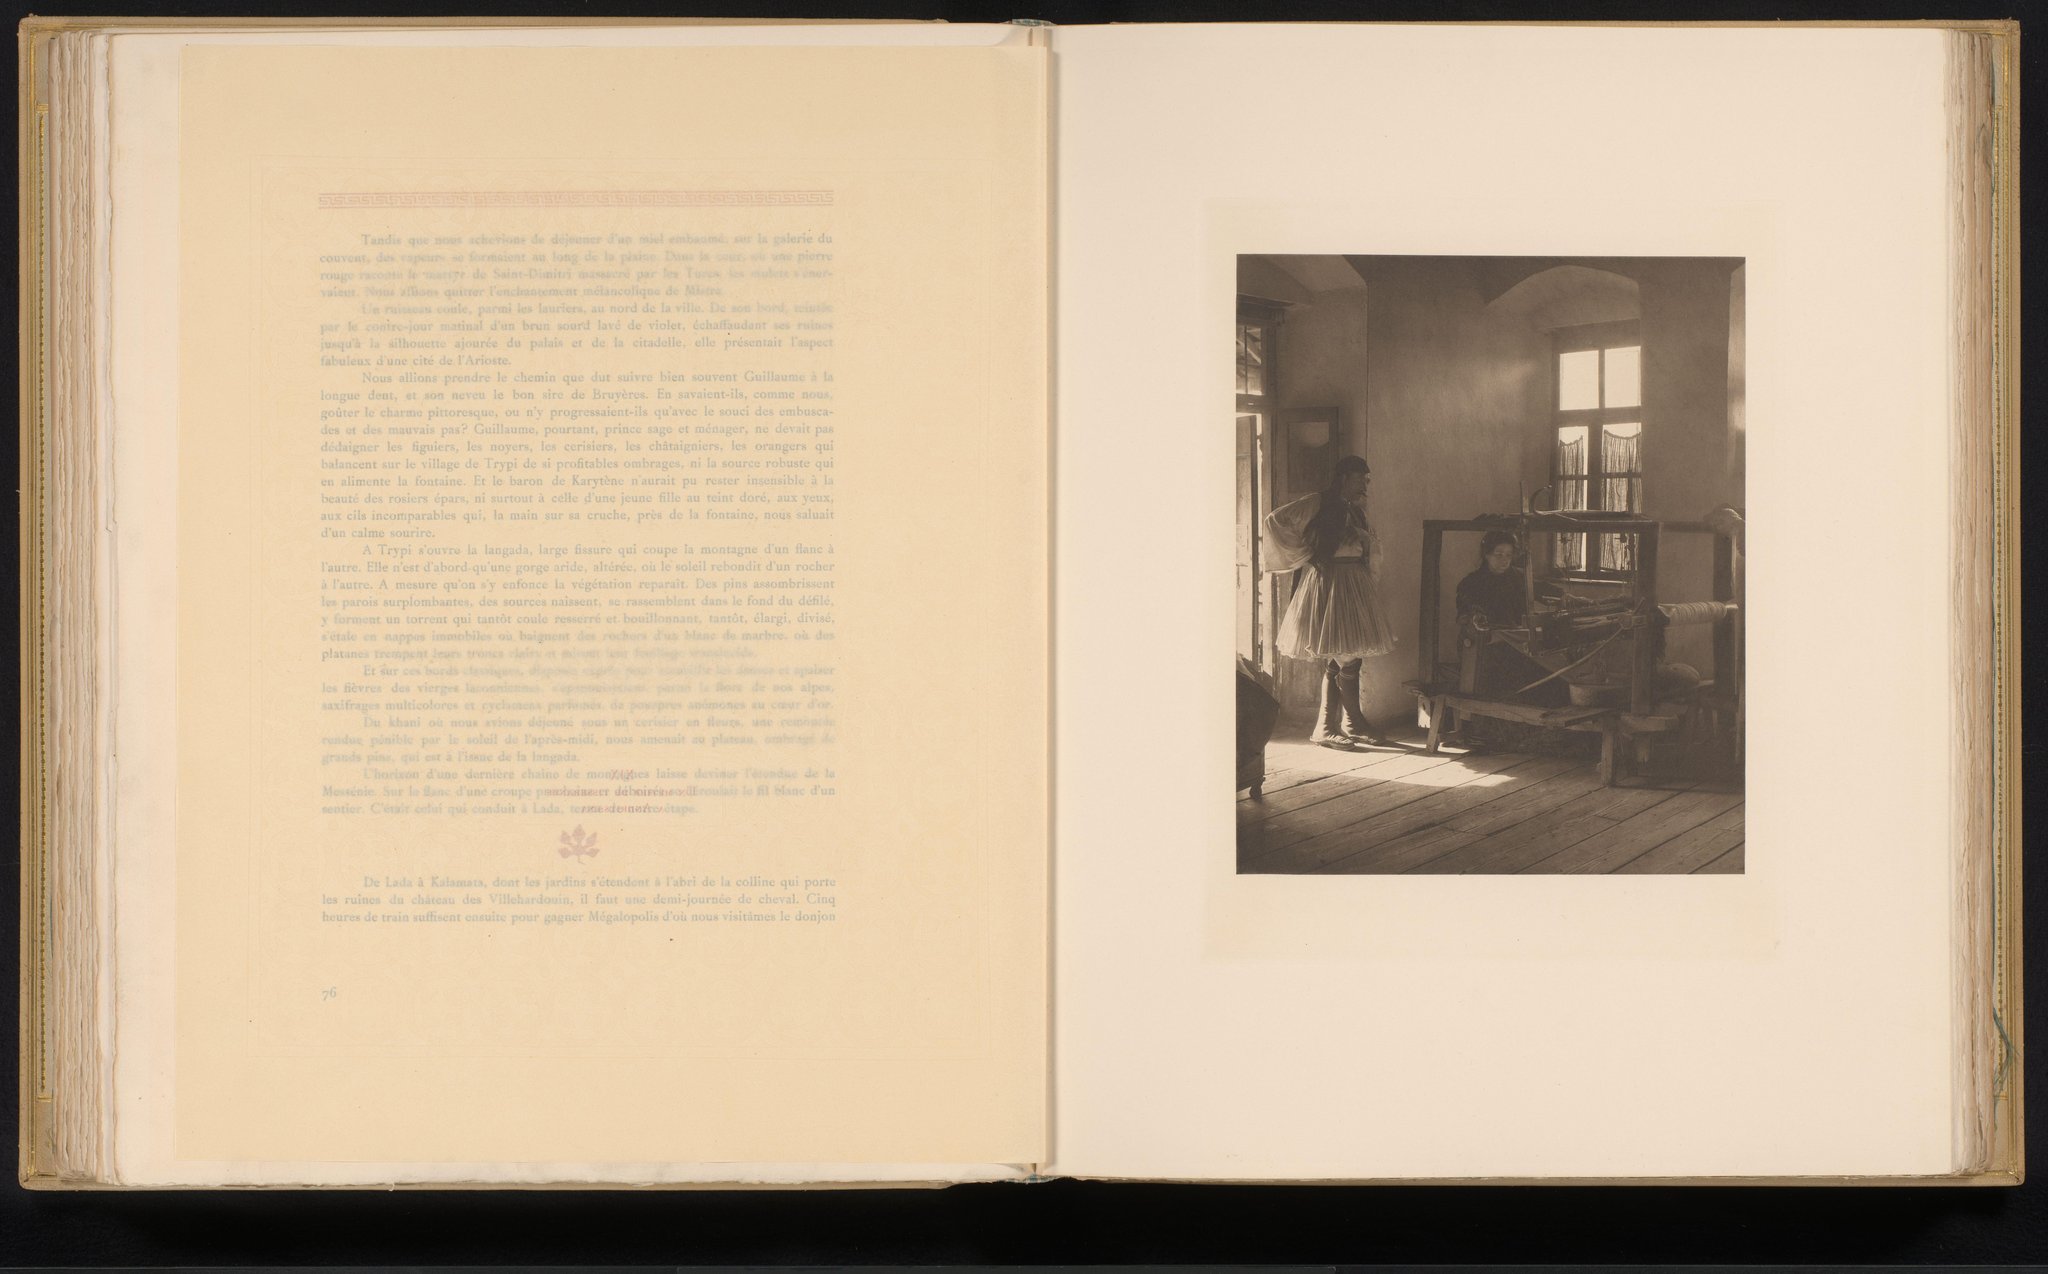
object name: photomechanical print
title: Man en vrouw bij een weefgetouw in Andritsaina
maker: frédéric boissonnas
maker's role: fotograaf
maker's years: 1858-1946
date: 1905-1910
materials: paper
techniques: photoaquatint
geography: andritsaina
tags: adult woman, adult man, weaving-loom